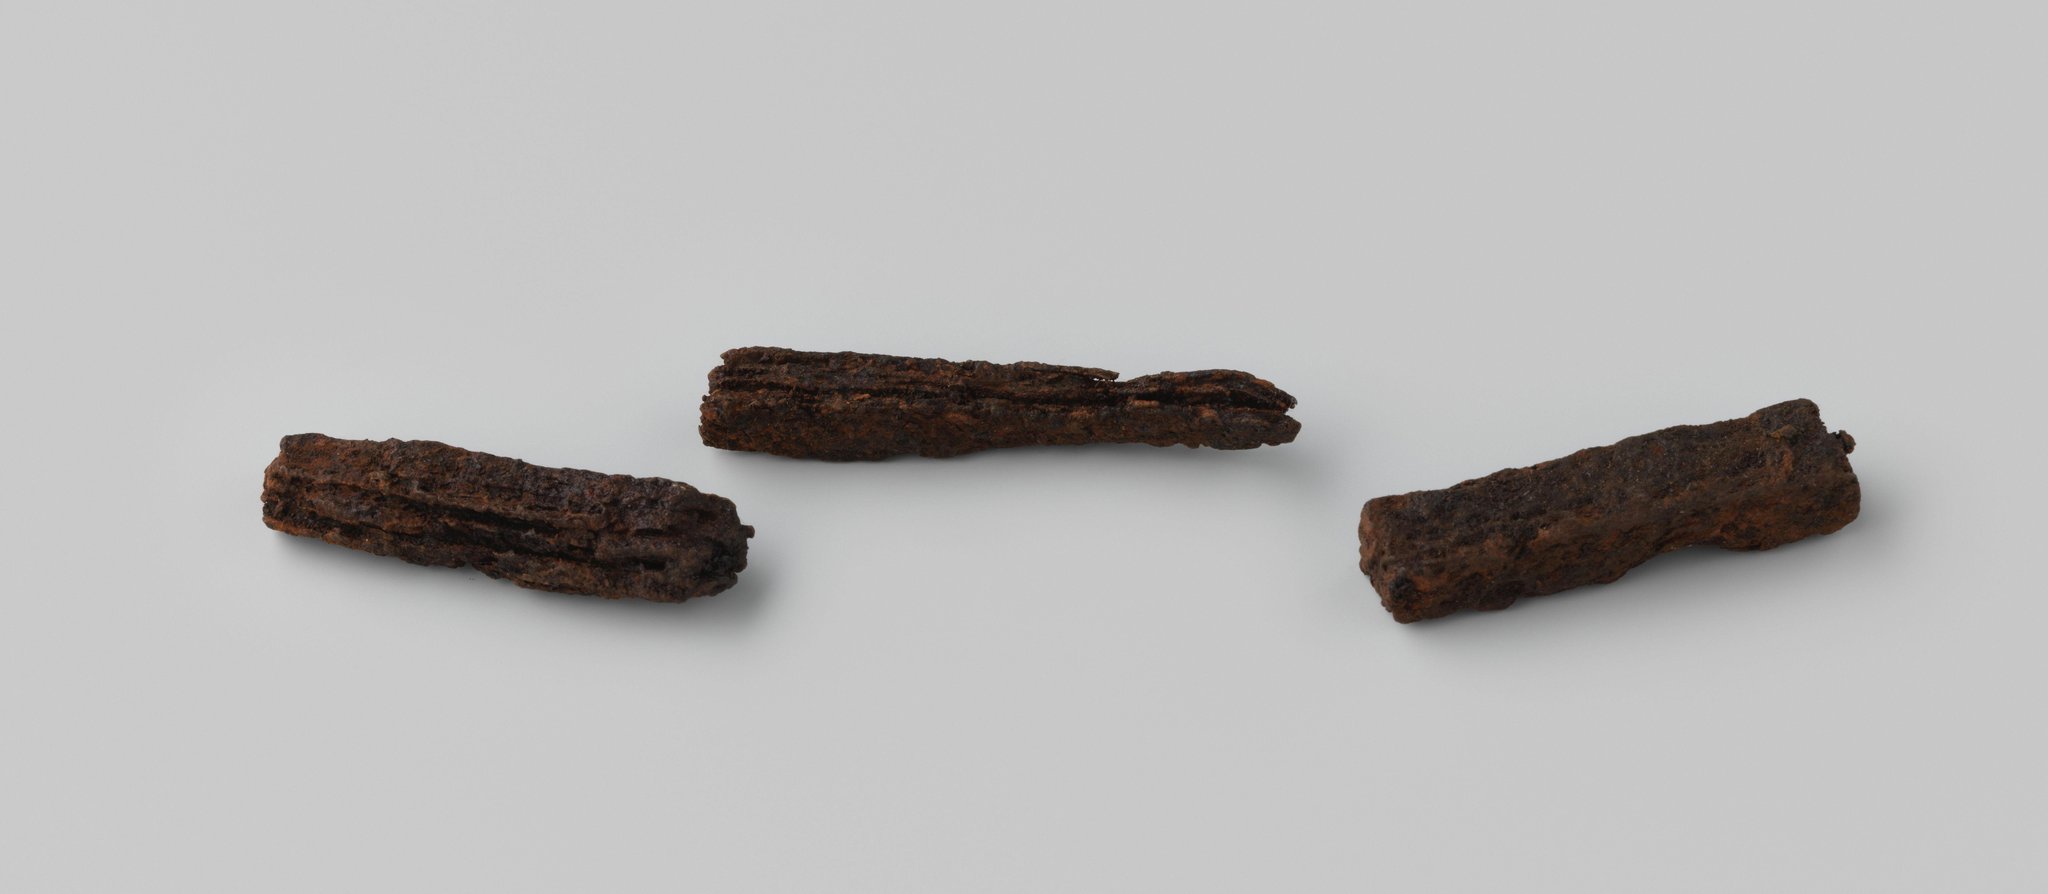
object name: part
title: Fragment of onderdeel uit het wrak van de Oost-Indiëvaarder Hollandia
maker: Anonymous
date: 1743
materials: iron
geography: netherlands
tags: verenigde oostindische compagnie, hollandia (schip), annet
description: Varied parts or fragments, bar(-shaped) fragments; fragm, heavily eroded, broken, sim. 80H2373.